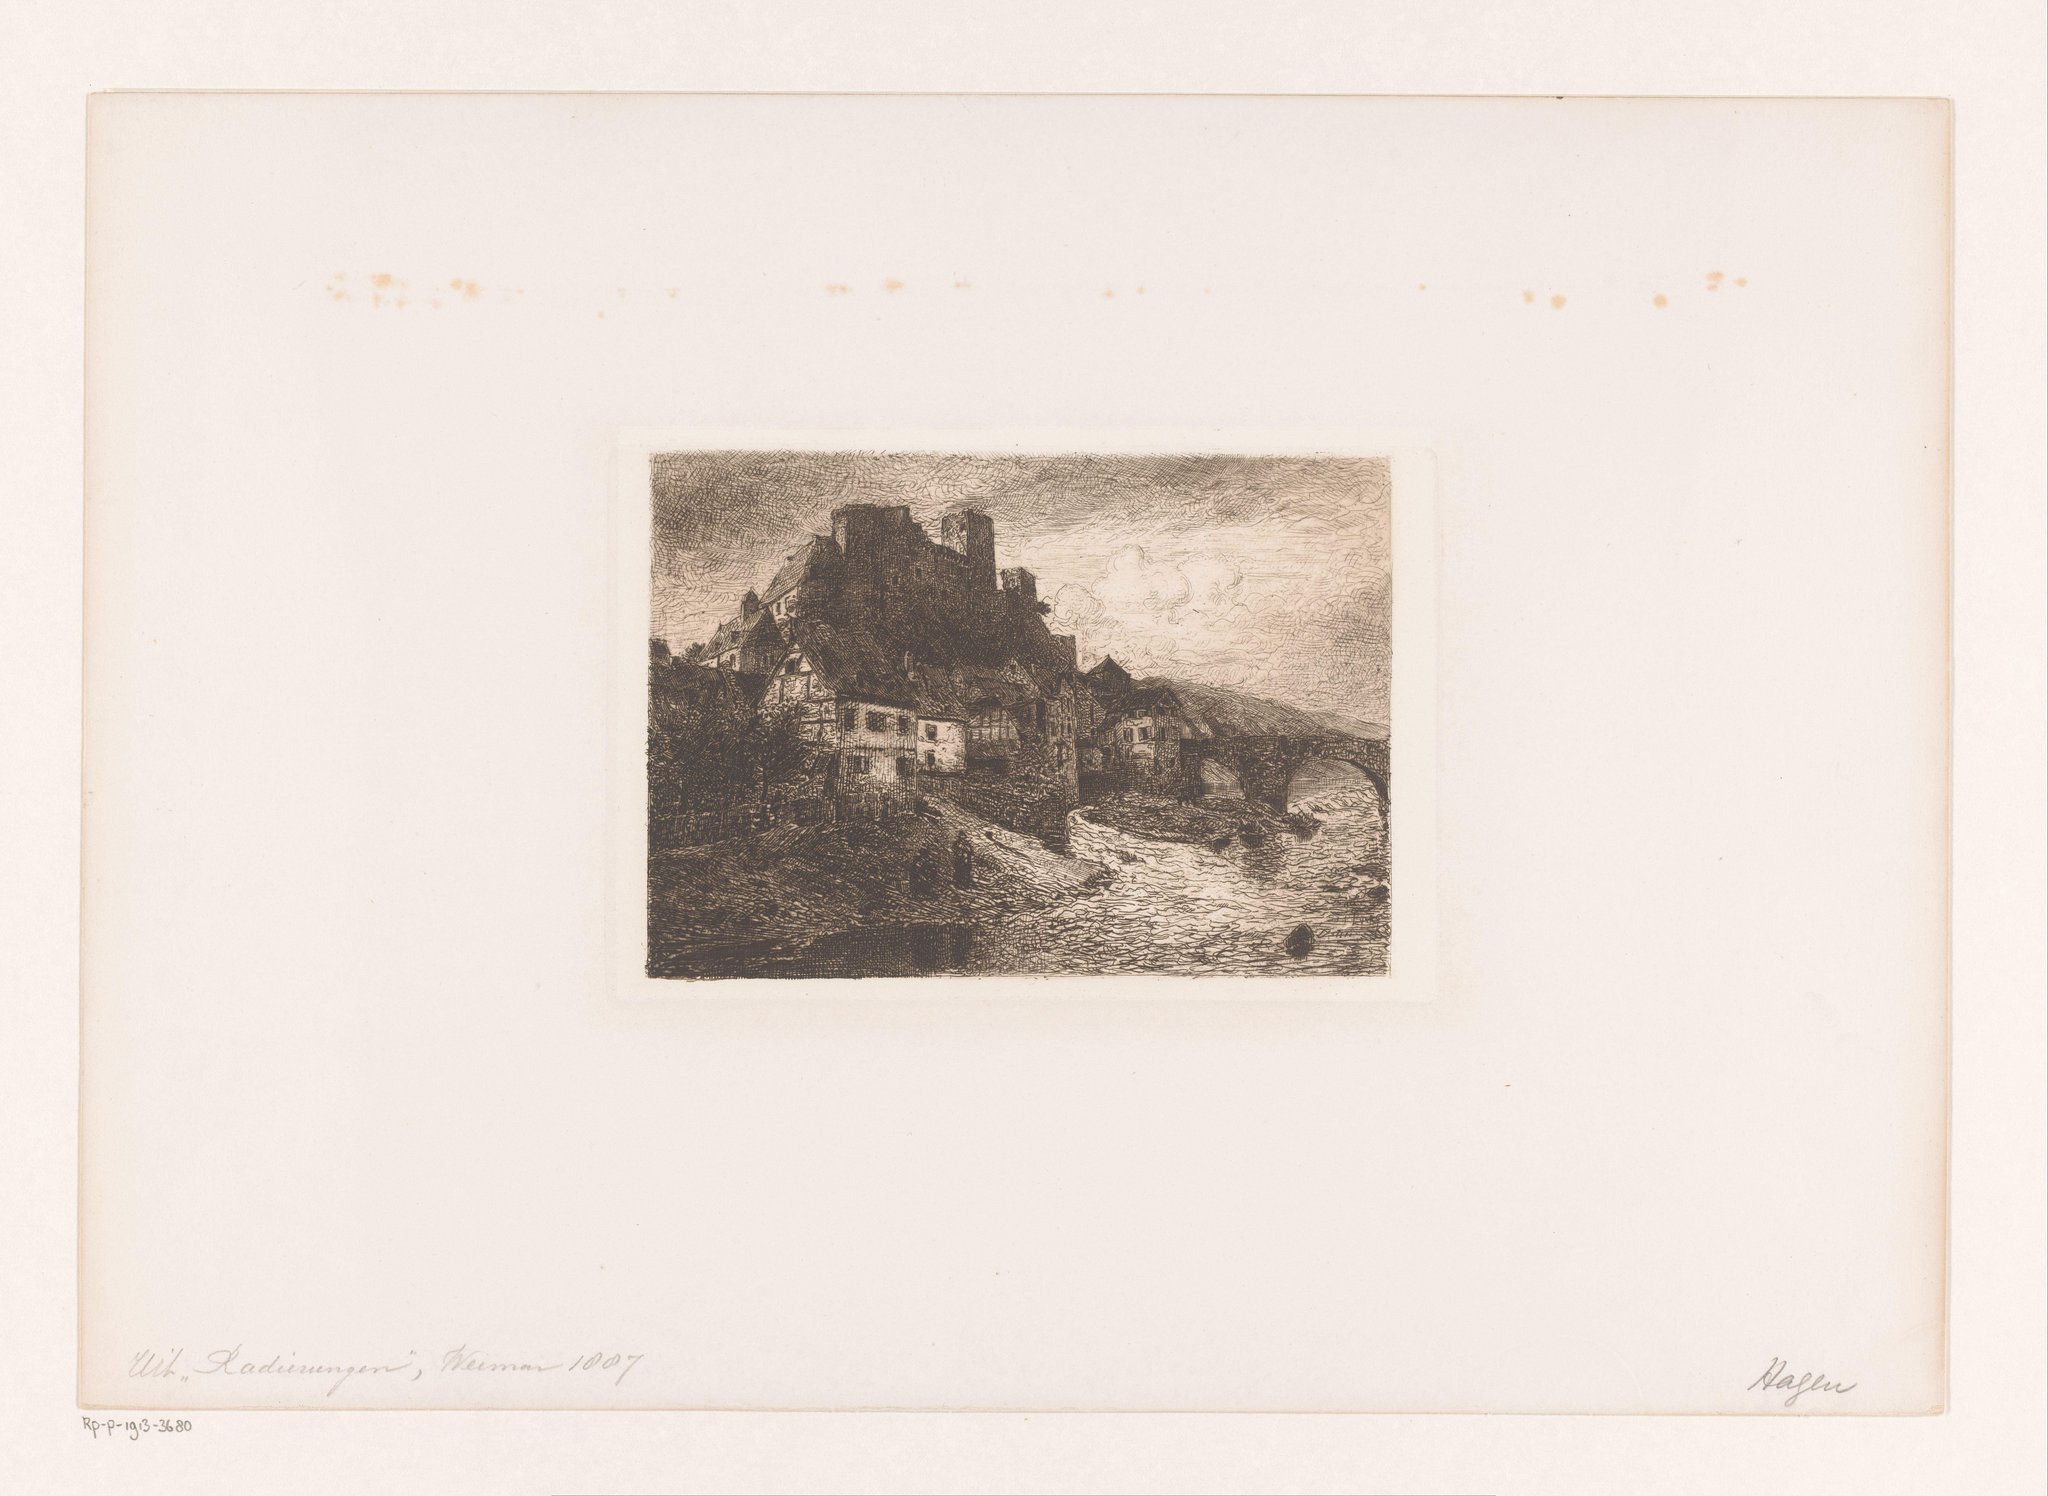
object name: print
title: Oude burcht en huizen aan een rivier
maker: theodor hagen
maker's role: print maker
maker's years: 1842-1919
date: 1887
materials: paper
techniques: etching, intaglio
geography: weimar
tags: castle, river (+ landscape with figures, staffage), city-view, and landscape with man-made constructions (+ city(-scape) with figures, staffage)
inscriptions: collector's mark: Lugt 2228, inscription: ‘Uit "Radigungen" Weimar 1887’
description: Prent maakt deel uit van een groep prenten die tussen 1880 en 1888 werd uitgegeven door het Gesellschaft für Radierkunst te Weimar.